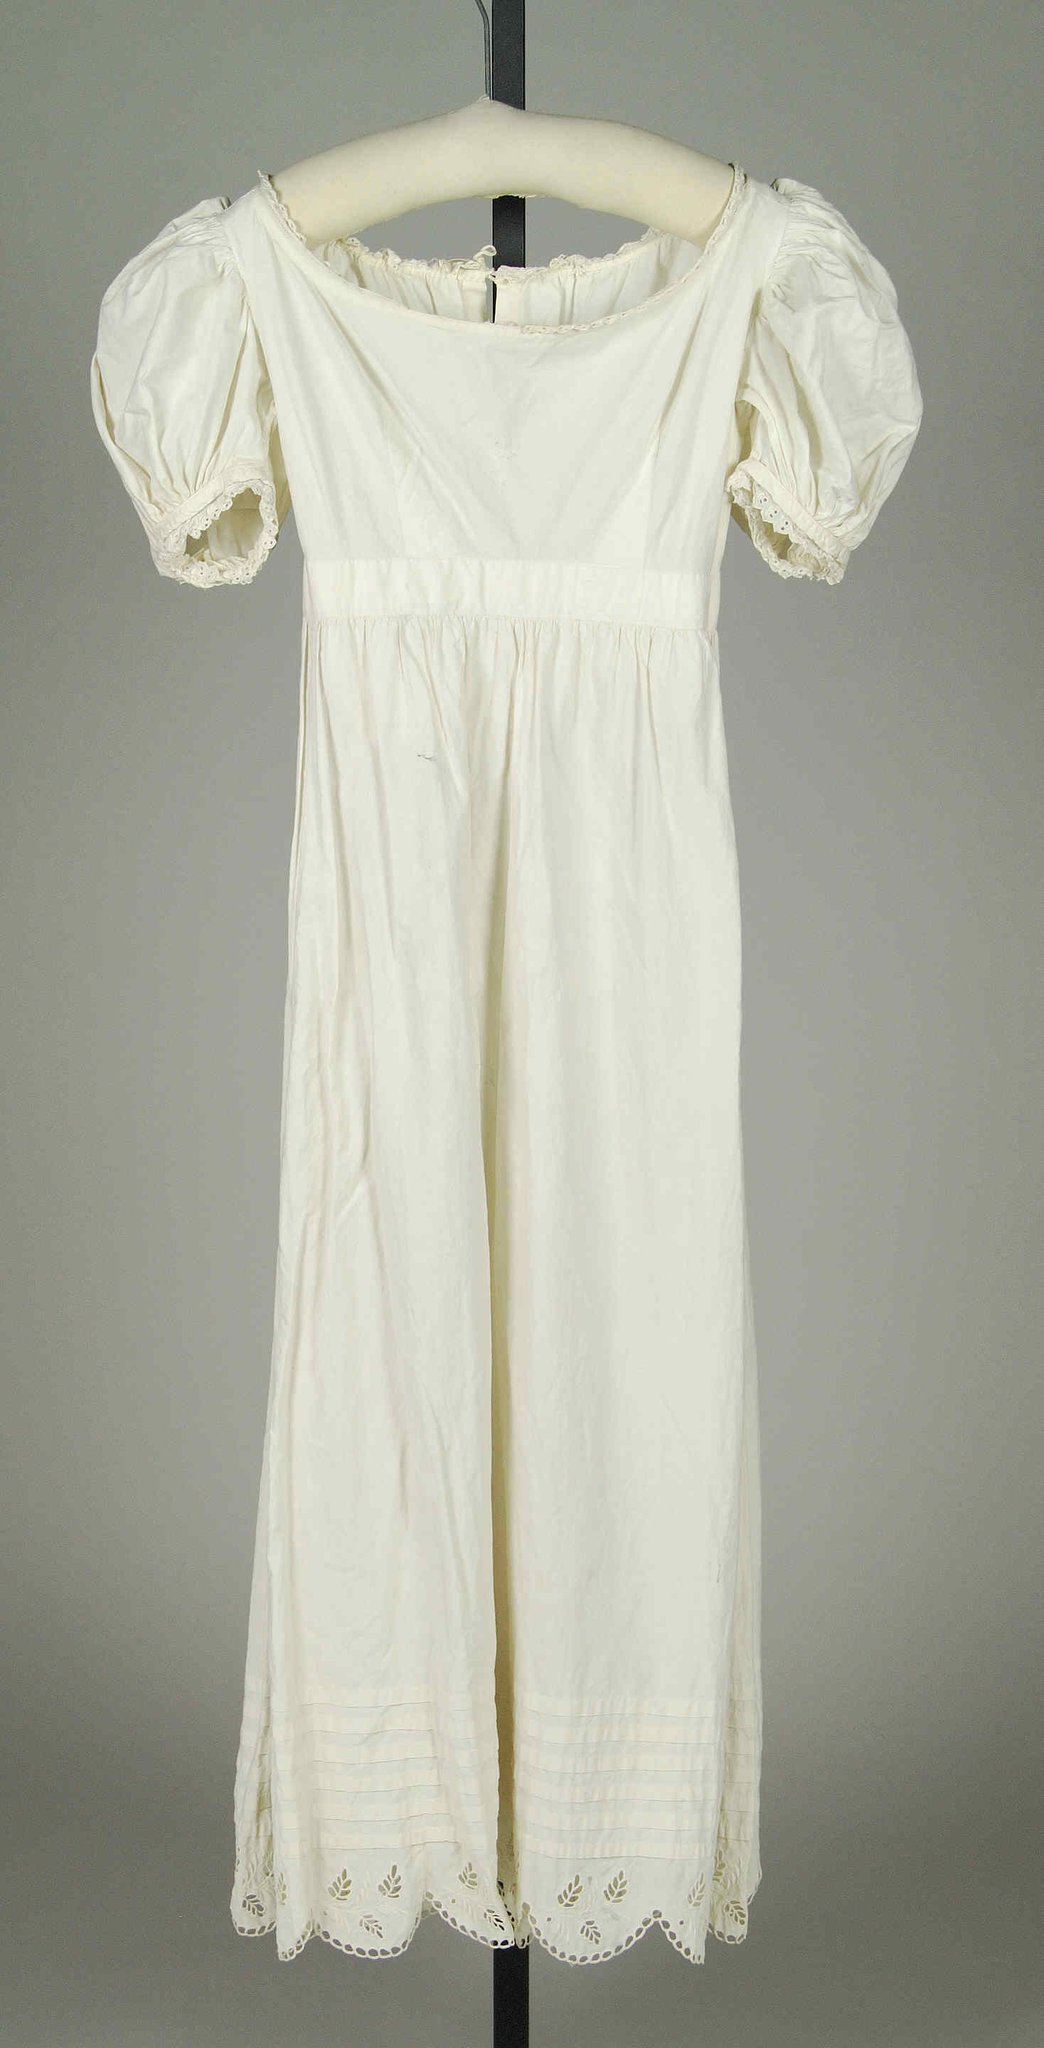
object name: underdress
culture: american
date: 1820-1825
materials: cotton